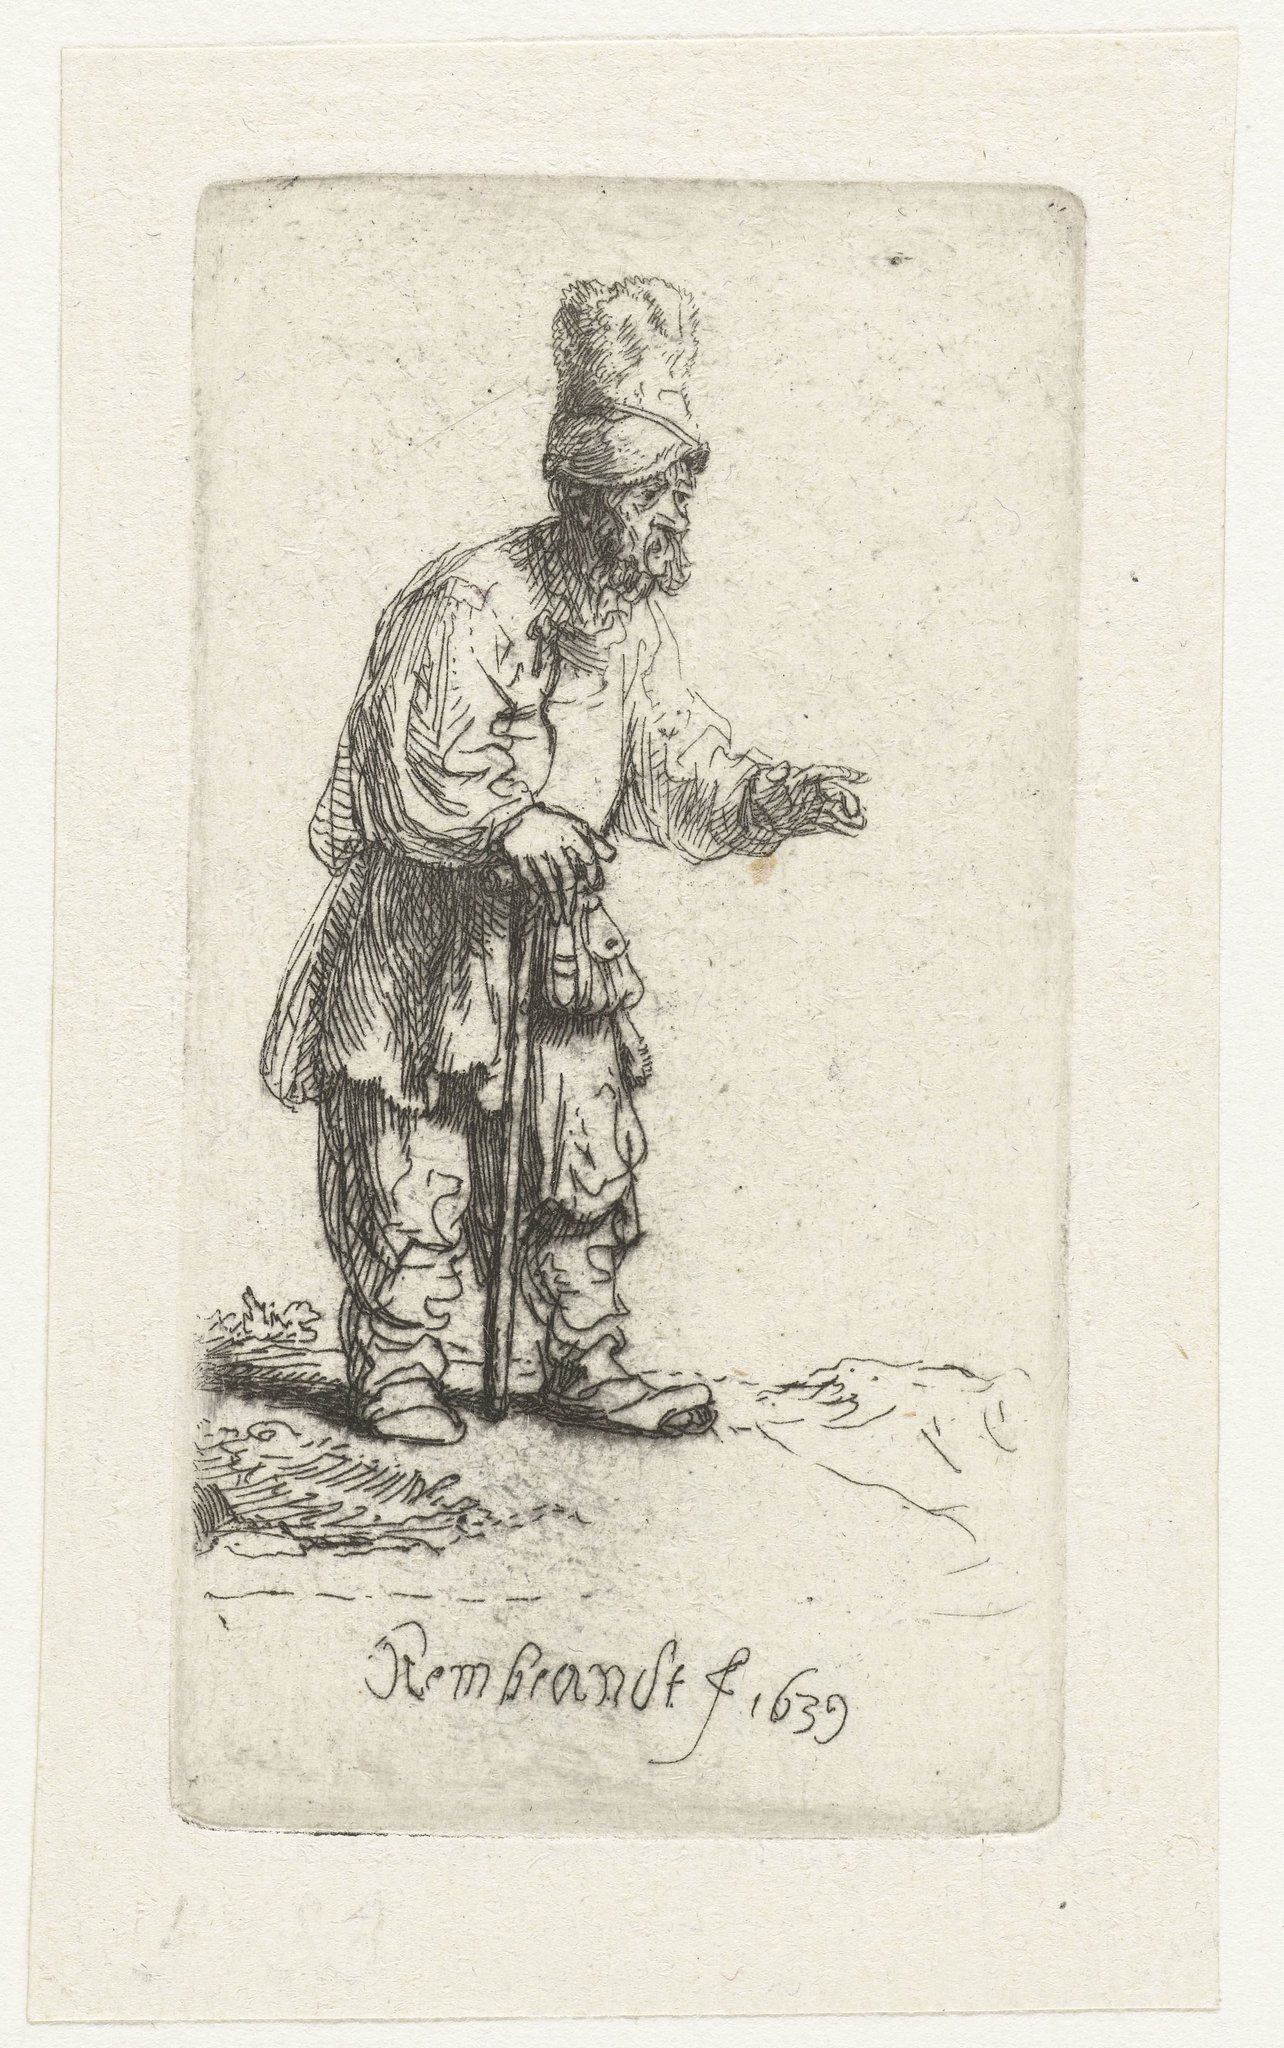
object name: print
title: A peasant in a high cap, standing leaning on a stick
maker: rembrandt van rijn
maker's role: draughtsman, painter, print maker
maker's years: 1606-1669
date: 1639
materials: paper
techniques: etching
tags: the ages of man (+ old male (human being))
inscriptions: inscription: ‘Coppier’, signature and date: ‘Rembrandt f. 1639’